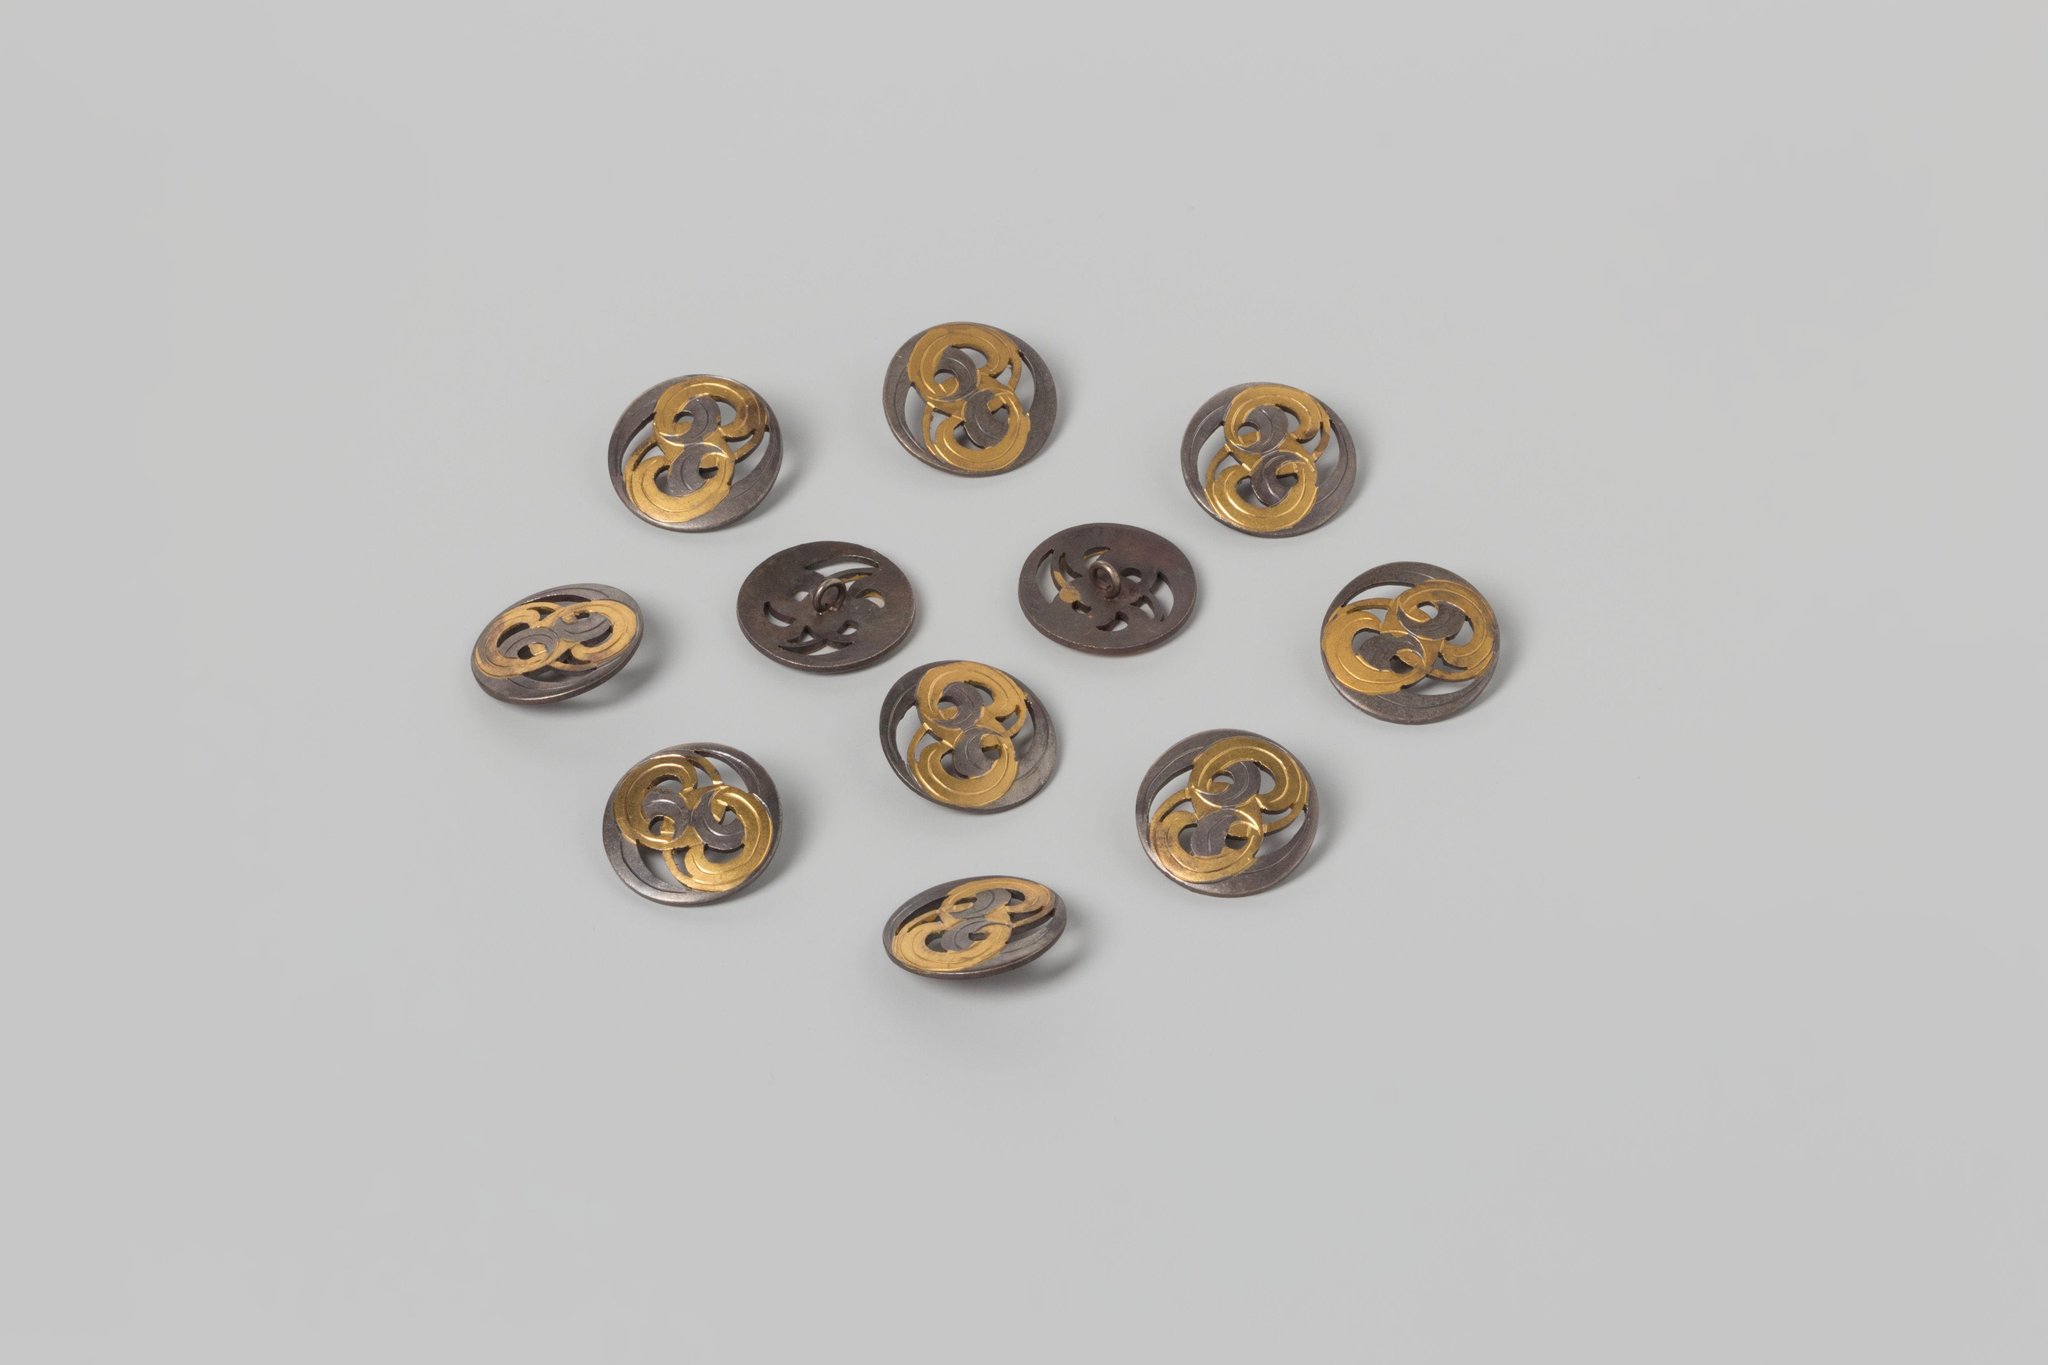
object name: button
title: Knoop, plat en rond, van gedeeltelijk met goudverf beschilderd metaal met krulmotief, opengewerkt en gegraveerd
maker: Anonymous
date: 1880-1940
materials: paint, metal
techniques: embroidery, engraving, painting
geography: europe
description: Knoop, plat en rond, van gedeeltelijk met goudverf beschilderd metaal met krulmotief, opengewerkt en gegraveerd, met oog aan de achterzijde.